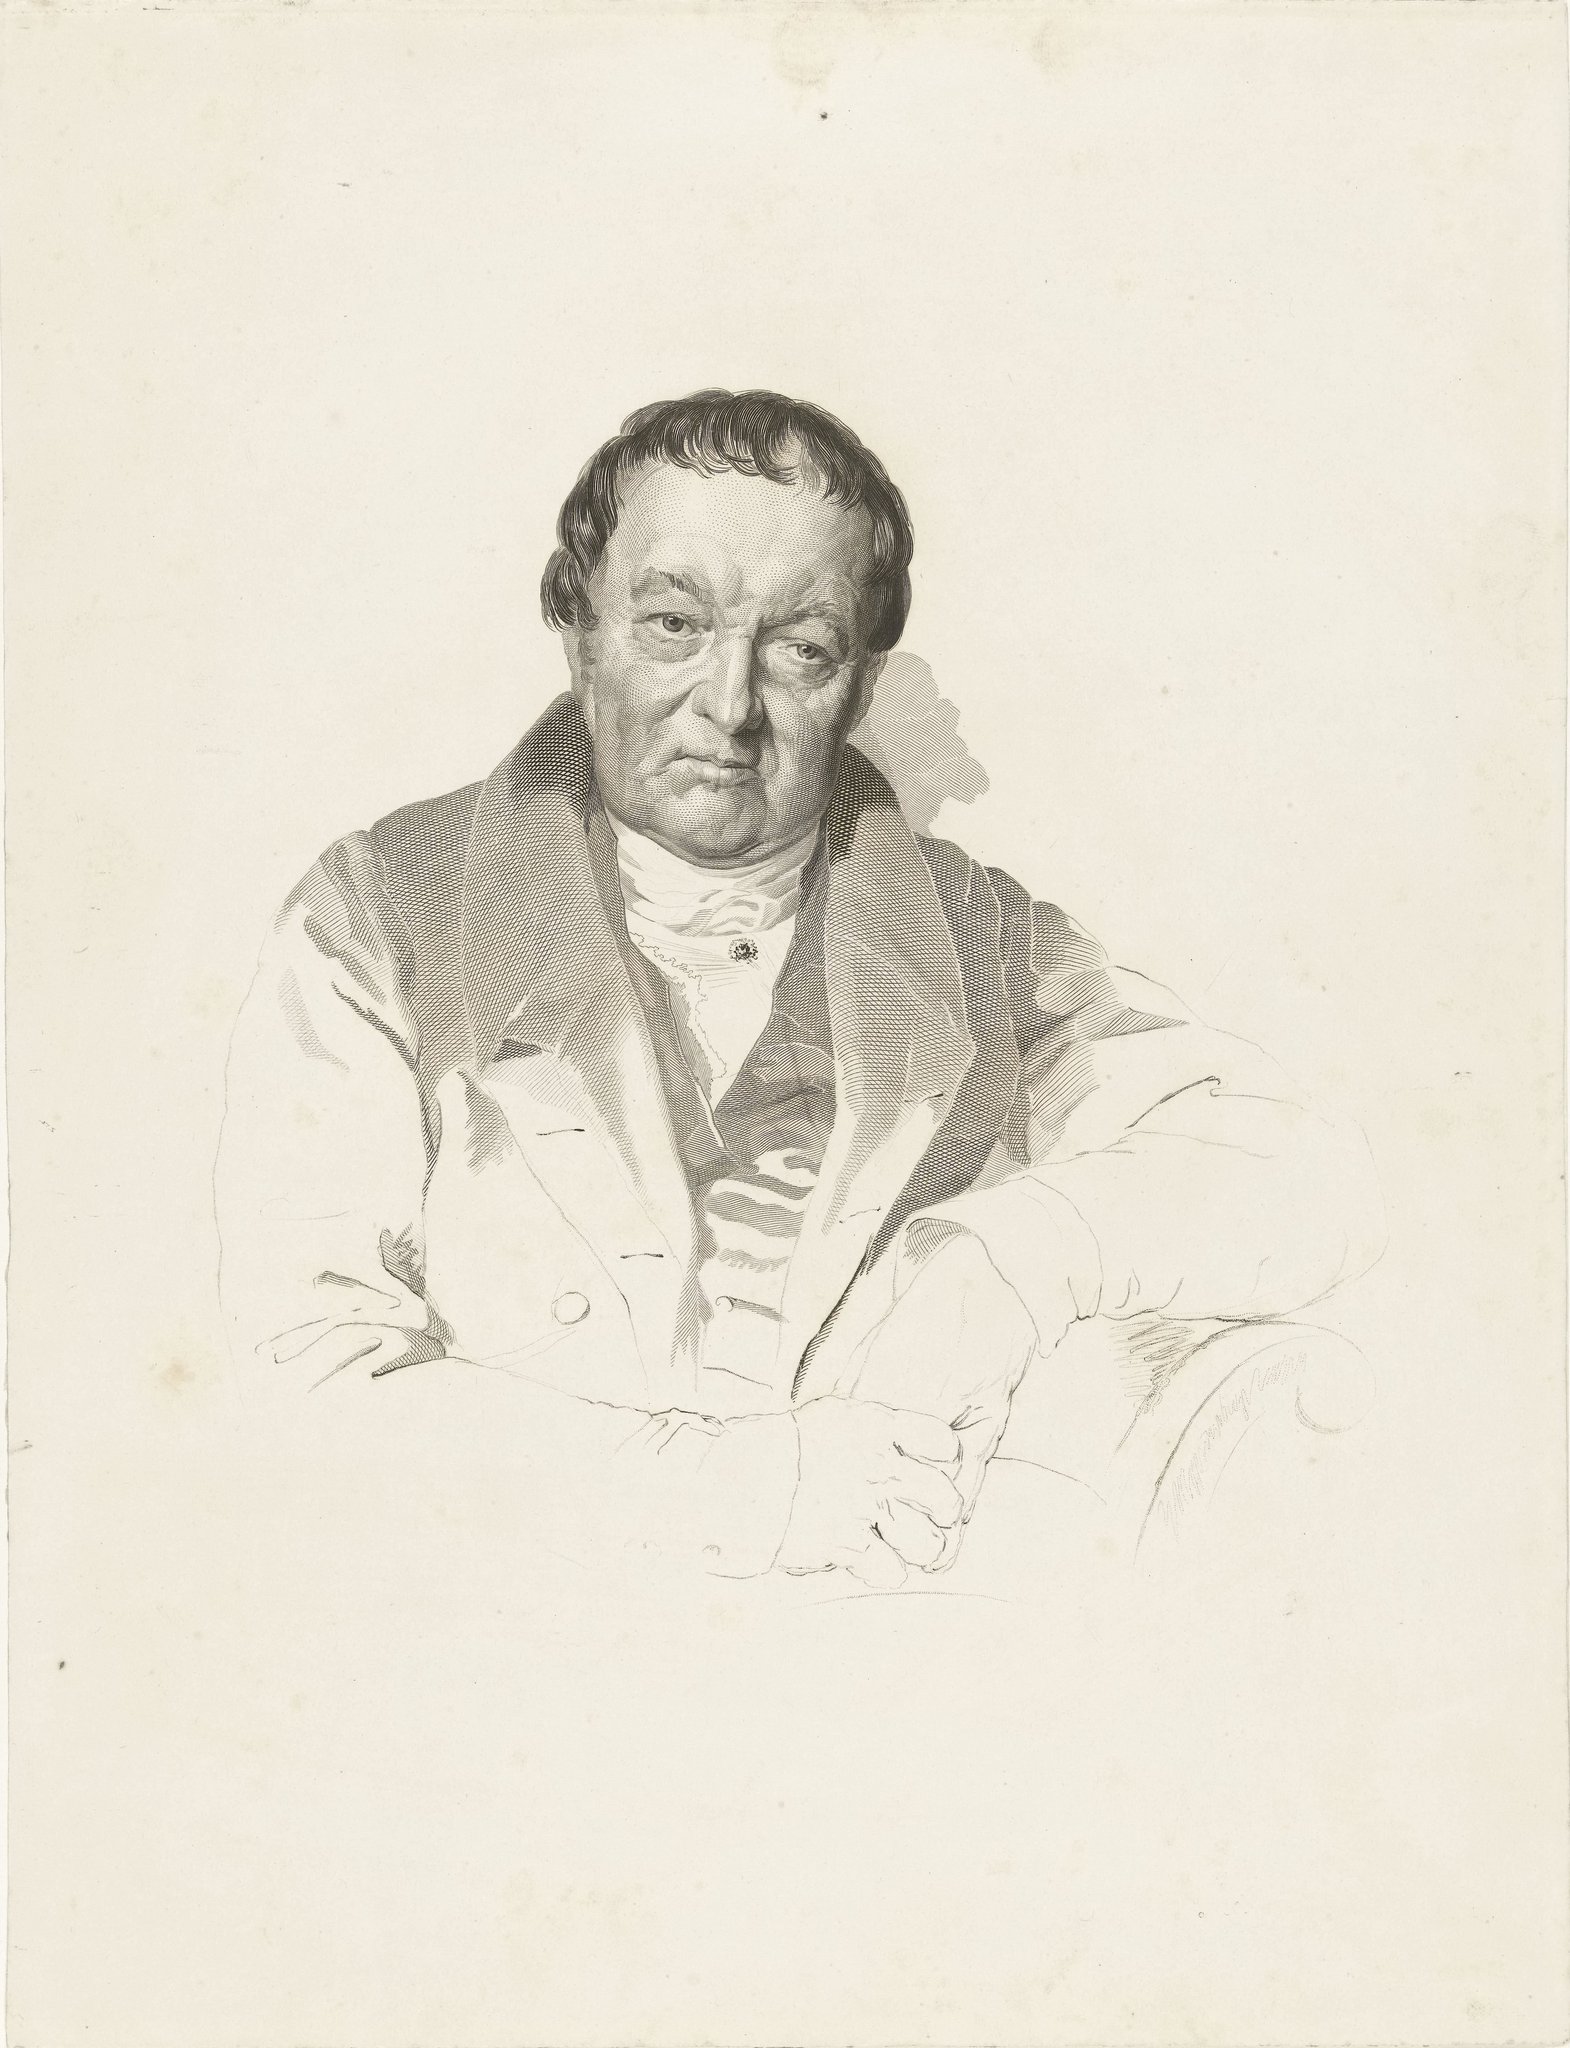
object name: print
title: Portret van de kunstverzamelaar Louis Splitgerber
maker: henricus wilhelmus couwenberg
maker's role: draughtsman, print maker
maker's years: 1814-1845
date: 1838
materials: paper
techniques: engraving, roulette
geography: amsterdam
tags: art collector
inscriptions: collector's mark: Lugt 2228